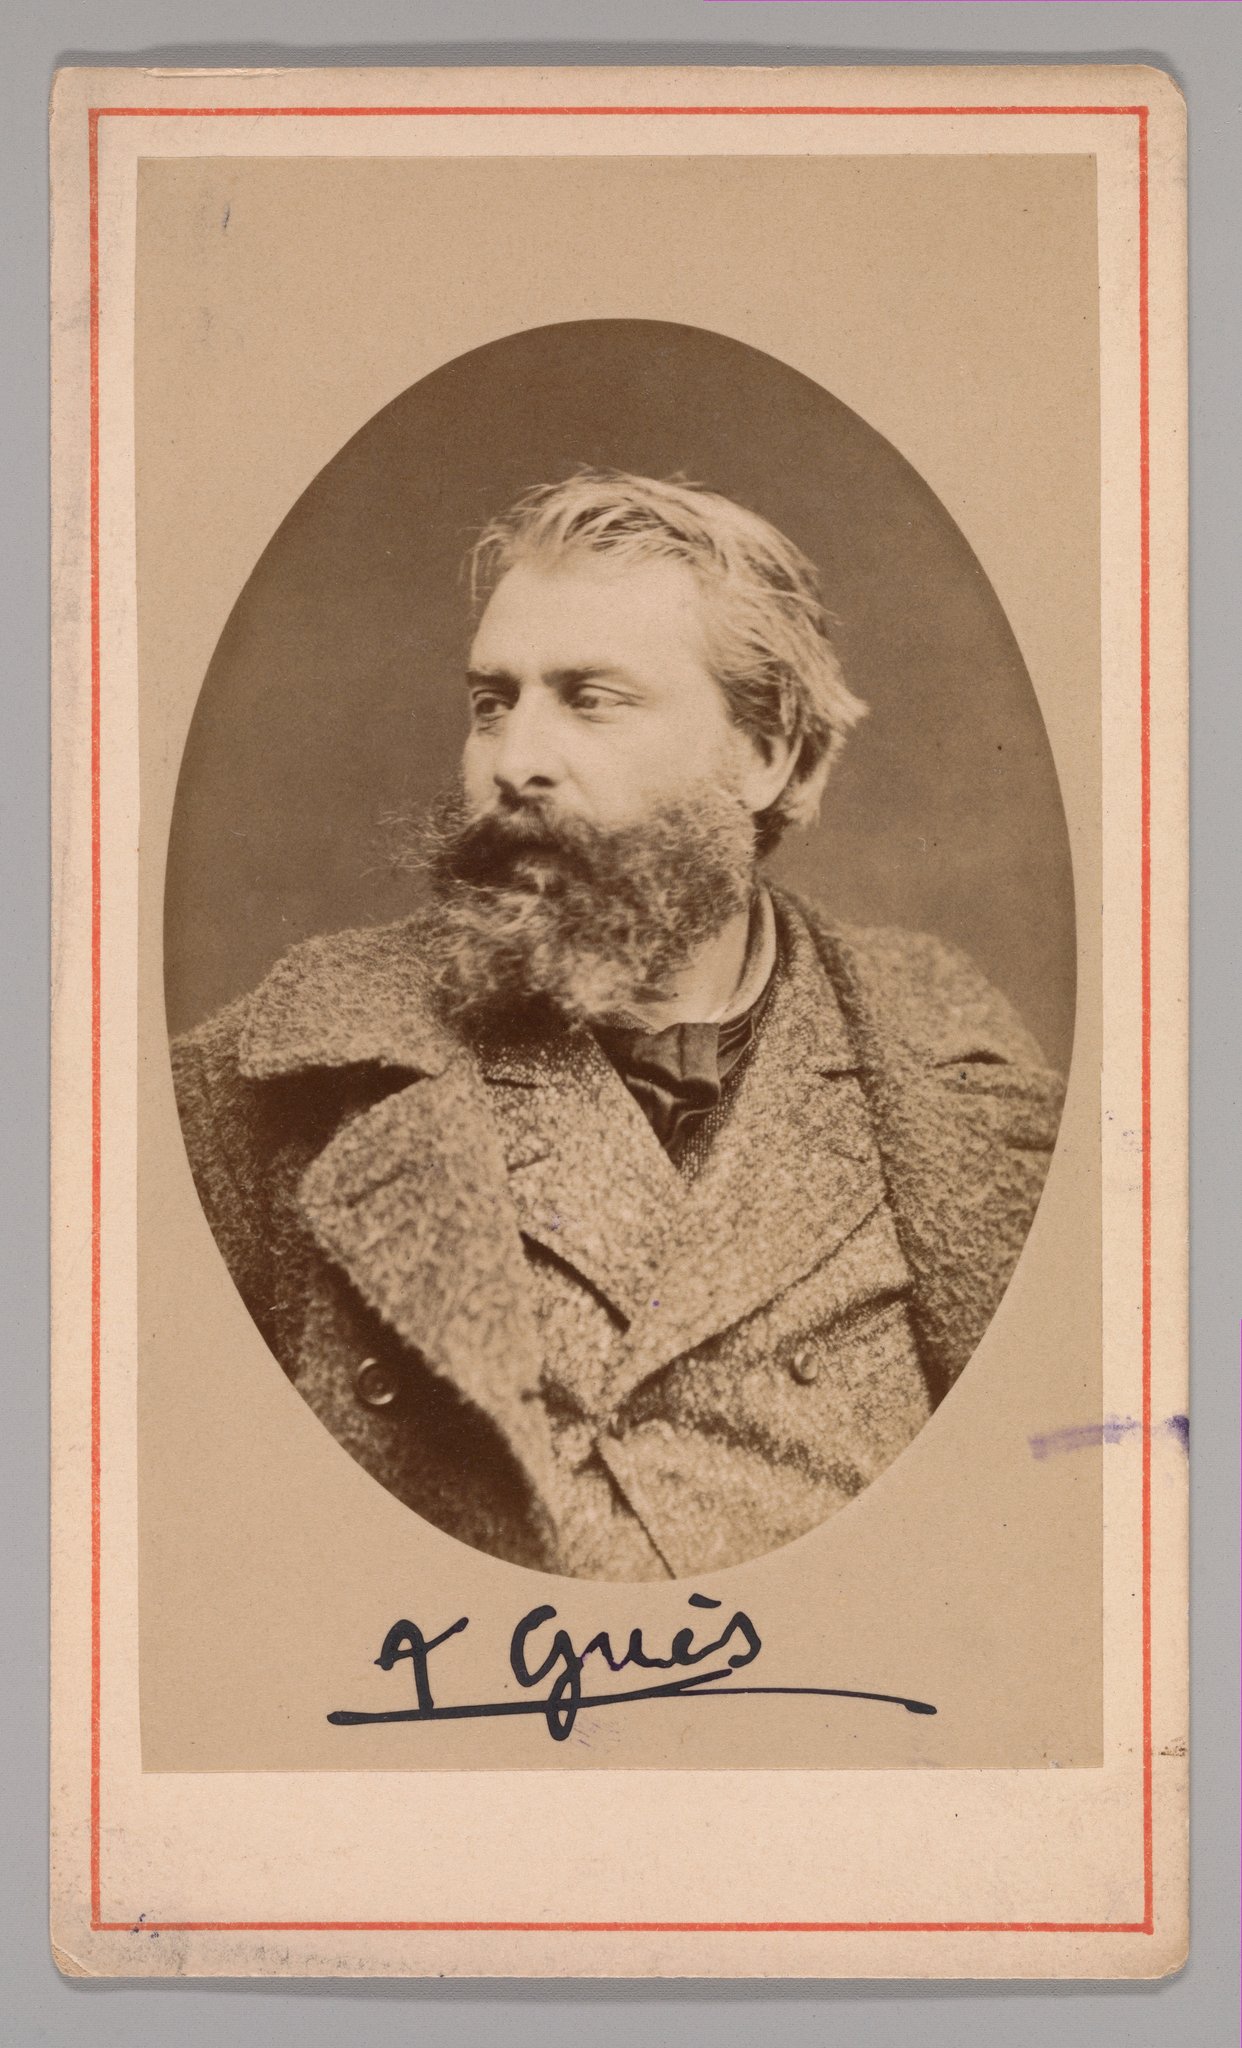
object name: carte de visite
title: [? Gres]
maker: Anonymous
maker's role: artist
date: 1860-1869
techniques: albumen silver print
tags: men,portraits